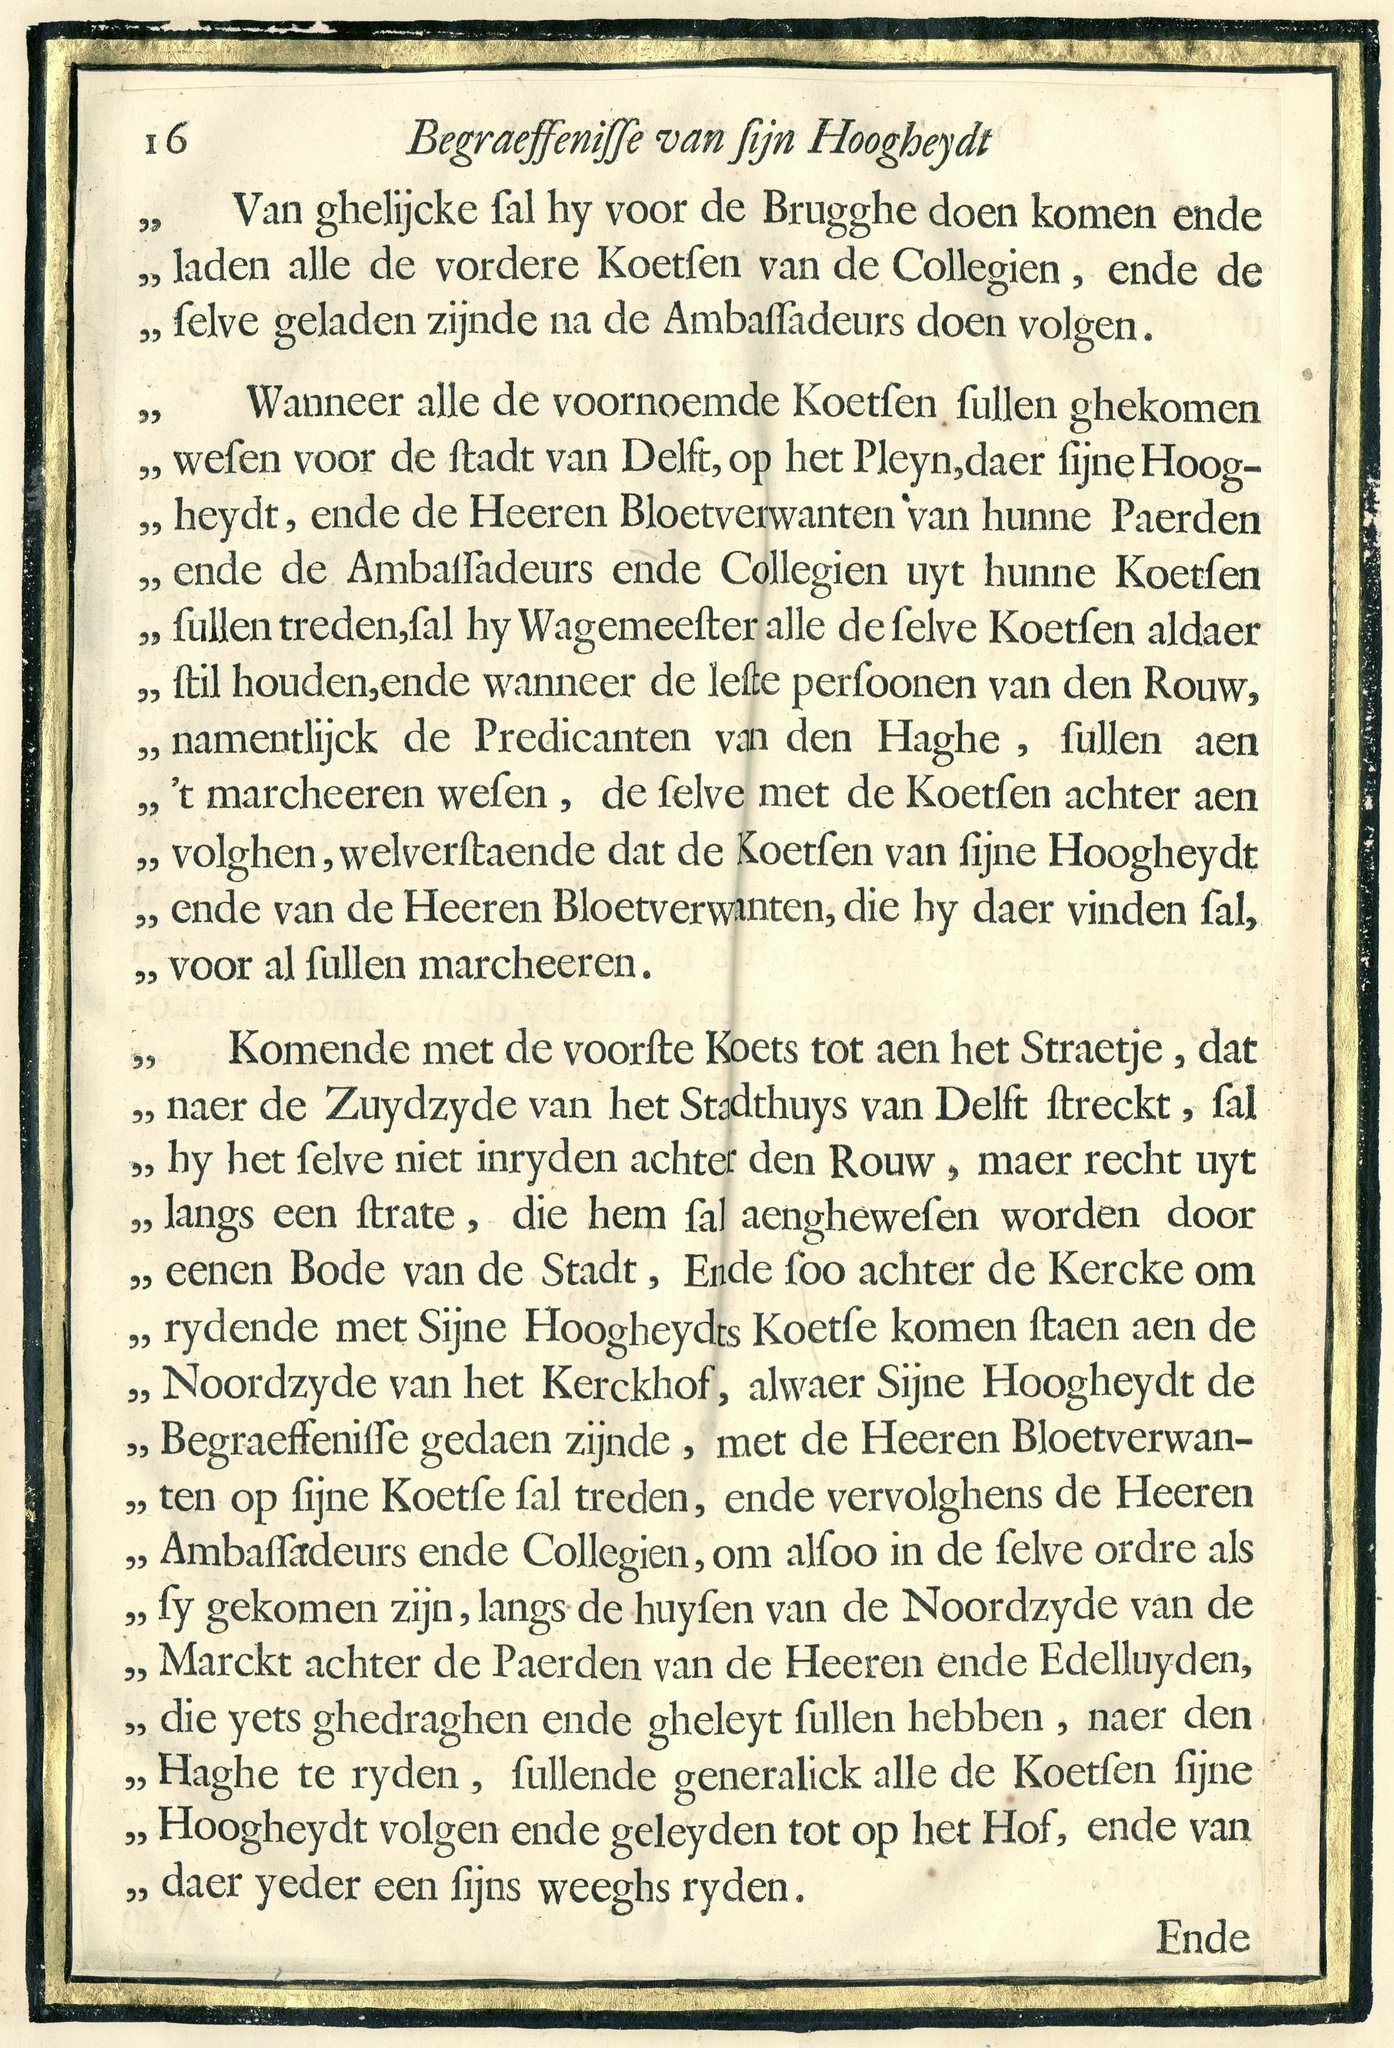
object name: book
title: Begraeffenisse van syne hoogheyt Frederick Henrick. Luxe ingekleurde uitgave van de prenten van de begrafenisstoet van Frederik Hendrik in 1647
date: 1651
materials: paint, paper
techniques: letterpress printing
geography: amsterdam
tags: delft, the hague, frederick henry (prince of orange)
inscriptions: date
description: Pagina16 van de beschrijving van de begrafenis van Frederik Hendrik. Blad uitgeknipt, versierd met goud en ingeplakt in de luxe editie uit ca. 1755 van het boek 'Begraeffenisse van syne hoogheyt Frederick Henrick' van Pieter Post, uitgegeven te Amsterdam in 1651.